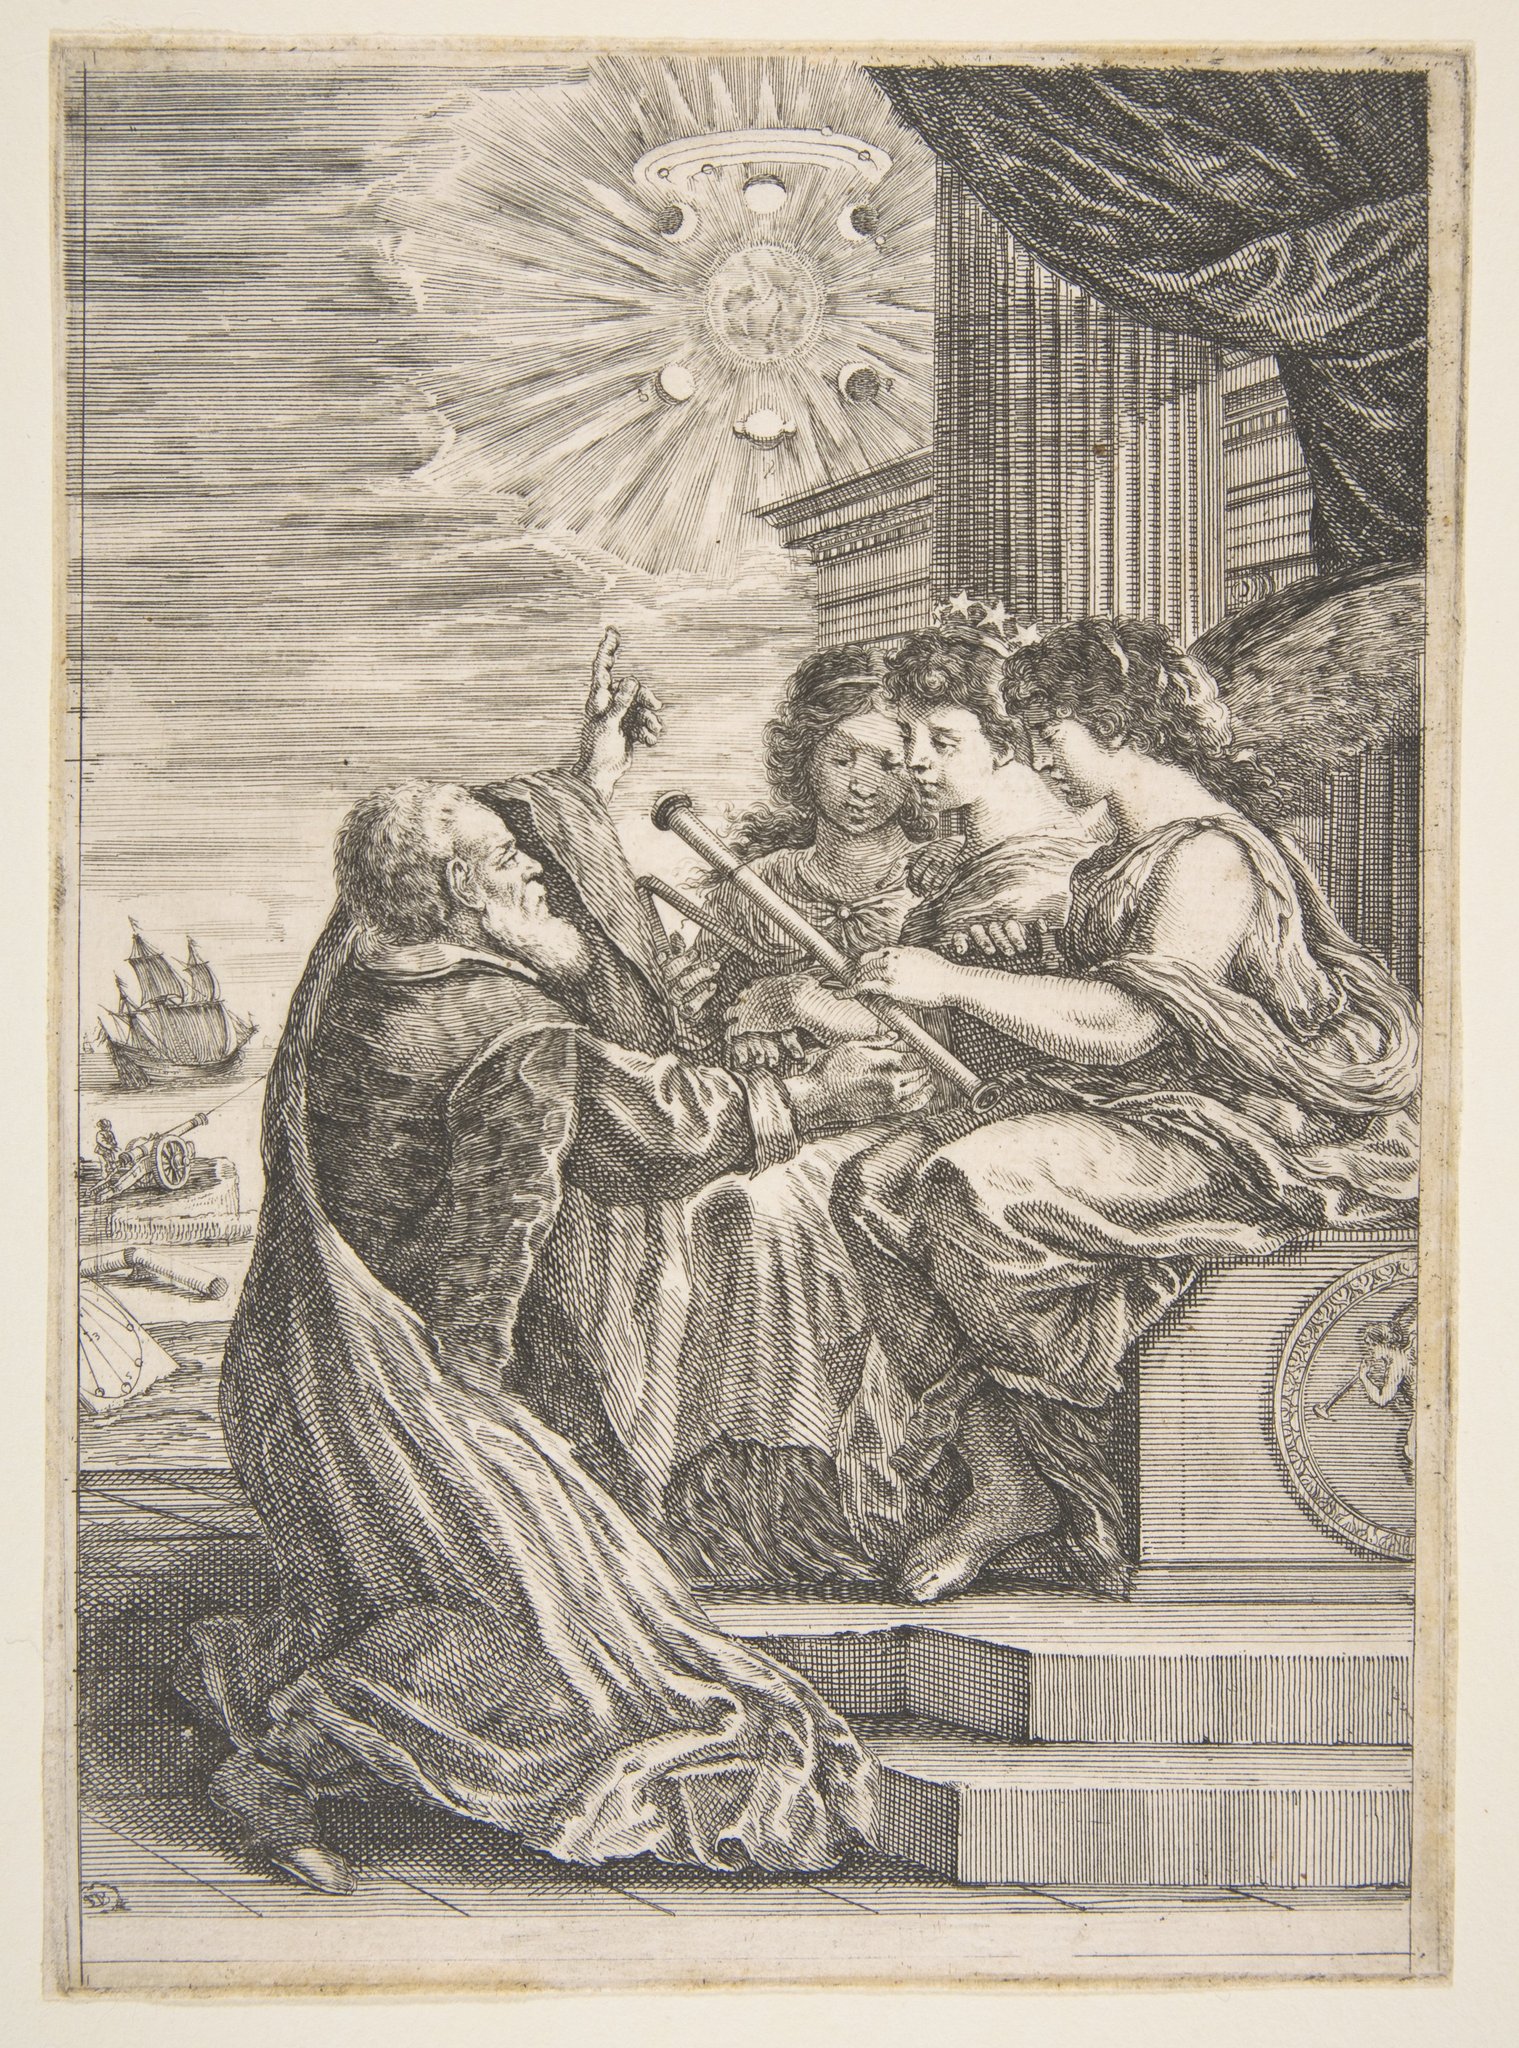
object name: print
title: Galileo and personifications of Astronomy, Perspective and Mathematics, frontispiece for 'Opere di Galileo Galilei'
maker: stefano della bella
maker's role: artist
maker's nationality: italian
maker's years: 1610-1664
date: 1656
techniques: etching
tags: men,women,astronomy